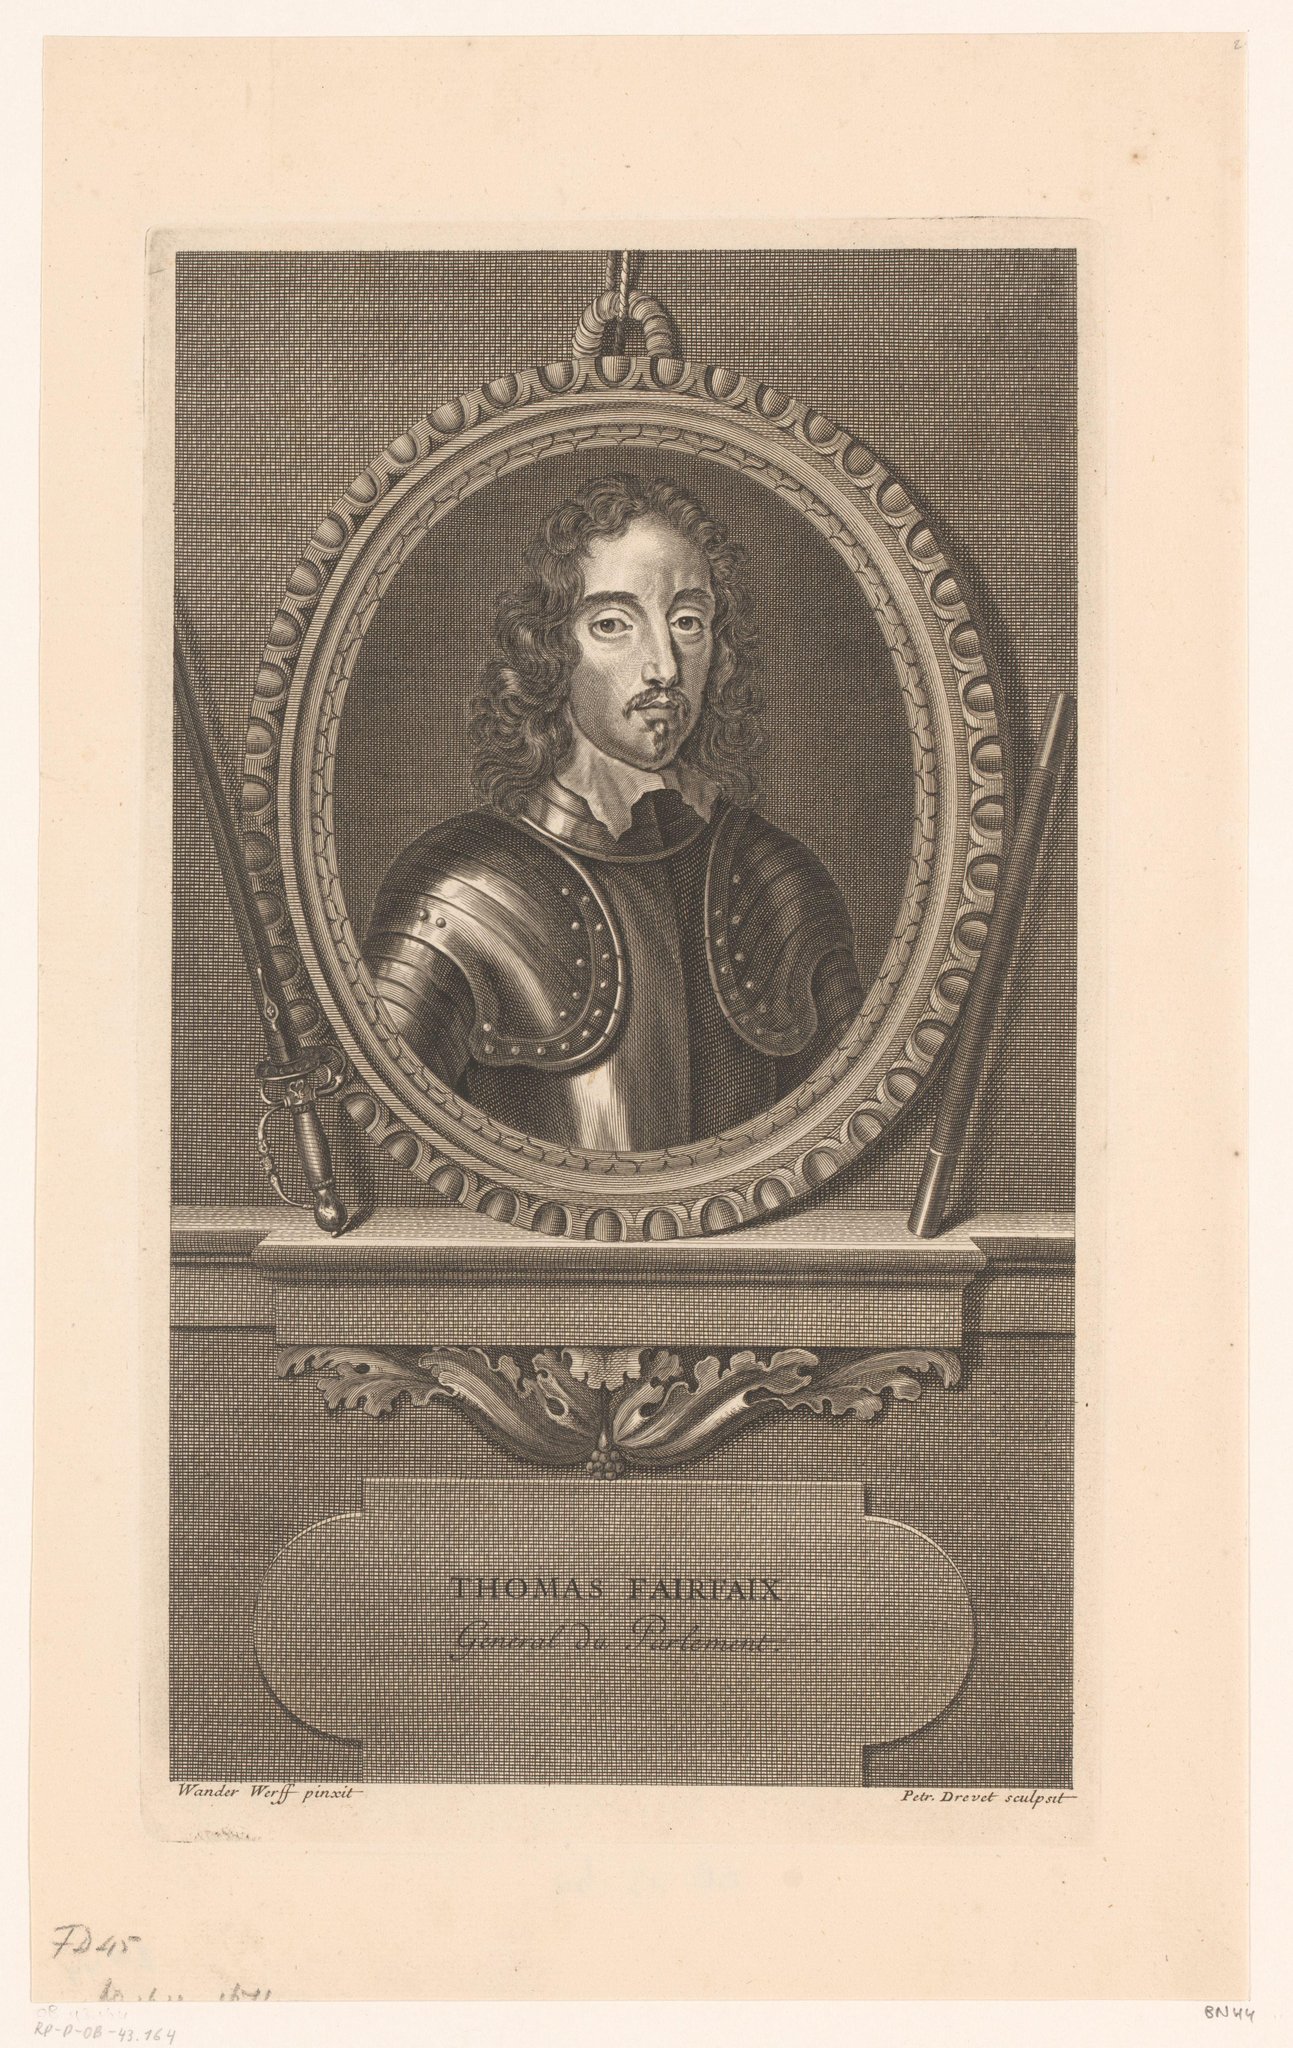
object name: print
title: Thomas Fairfax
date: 1673-1738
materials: paper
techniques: engraving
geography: france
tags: ornament ~ medallion, historical persons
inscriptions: collector's mark: Lugt 2228